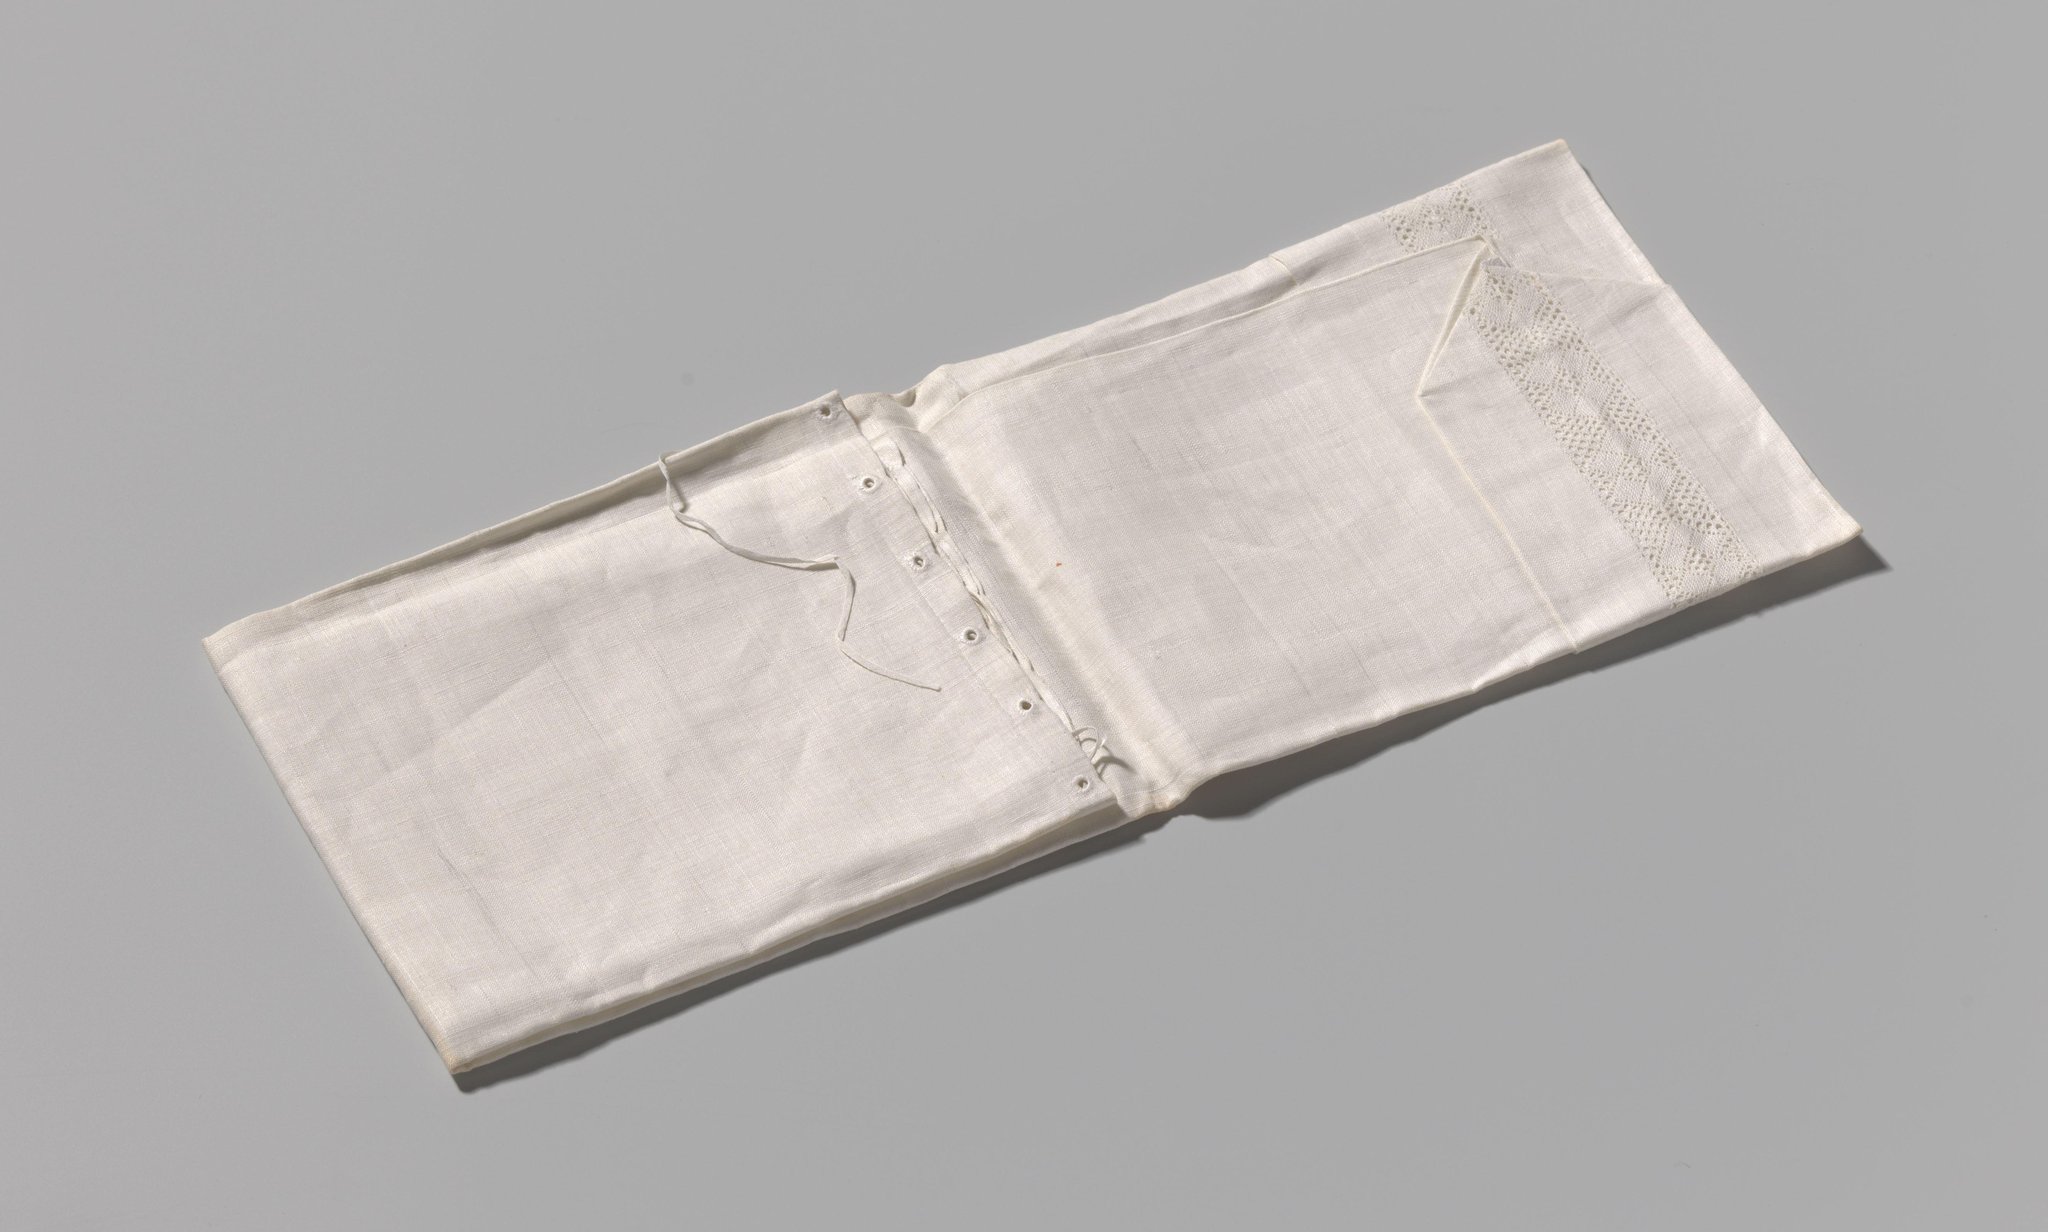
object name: sloop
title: Sloop met tussenzetsel. Merk: kroon GW6 Jaartal 1728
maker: Anonymous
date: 1728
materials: linen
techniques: lace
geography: netherlands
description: Sloop van wit linnen met tussenzetsel van kloskant met geometrisch patroon, merk kroon GW 6 1728.